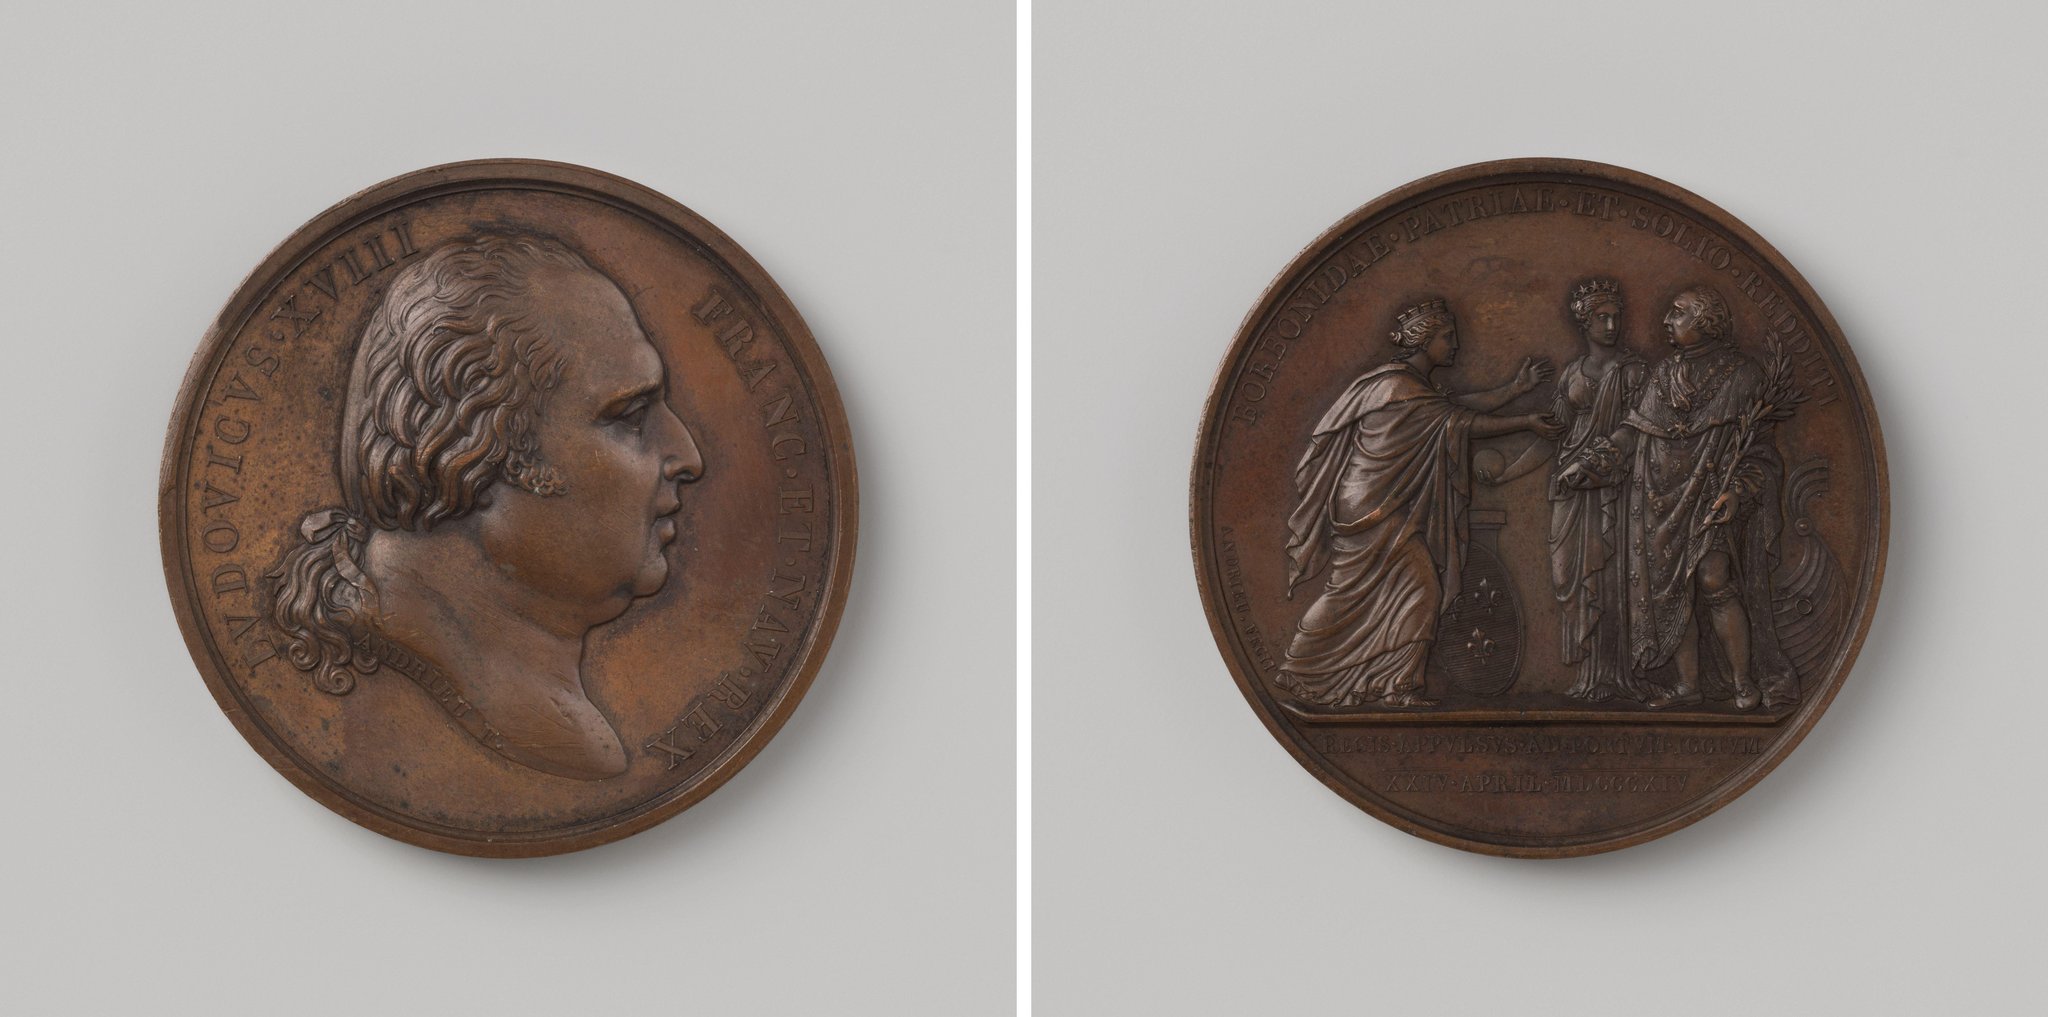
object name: history medal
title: Restauratie van de Bourbons op de Franse troon, ter ere van Lodewijk XVIII, koning van Frankrijk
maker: bertrand andrieu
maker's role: print maker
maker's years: 1761-1822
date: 1814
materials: bronze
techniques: striking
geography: paris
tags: paris, lodewijk xviii (koning van frankrijk), france